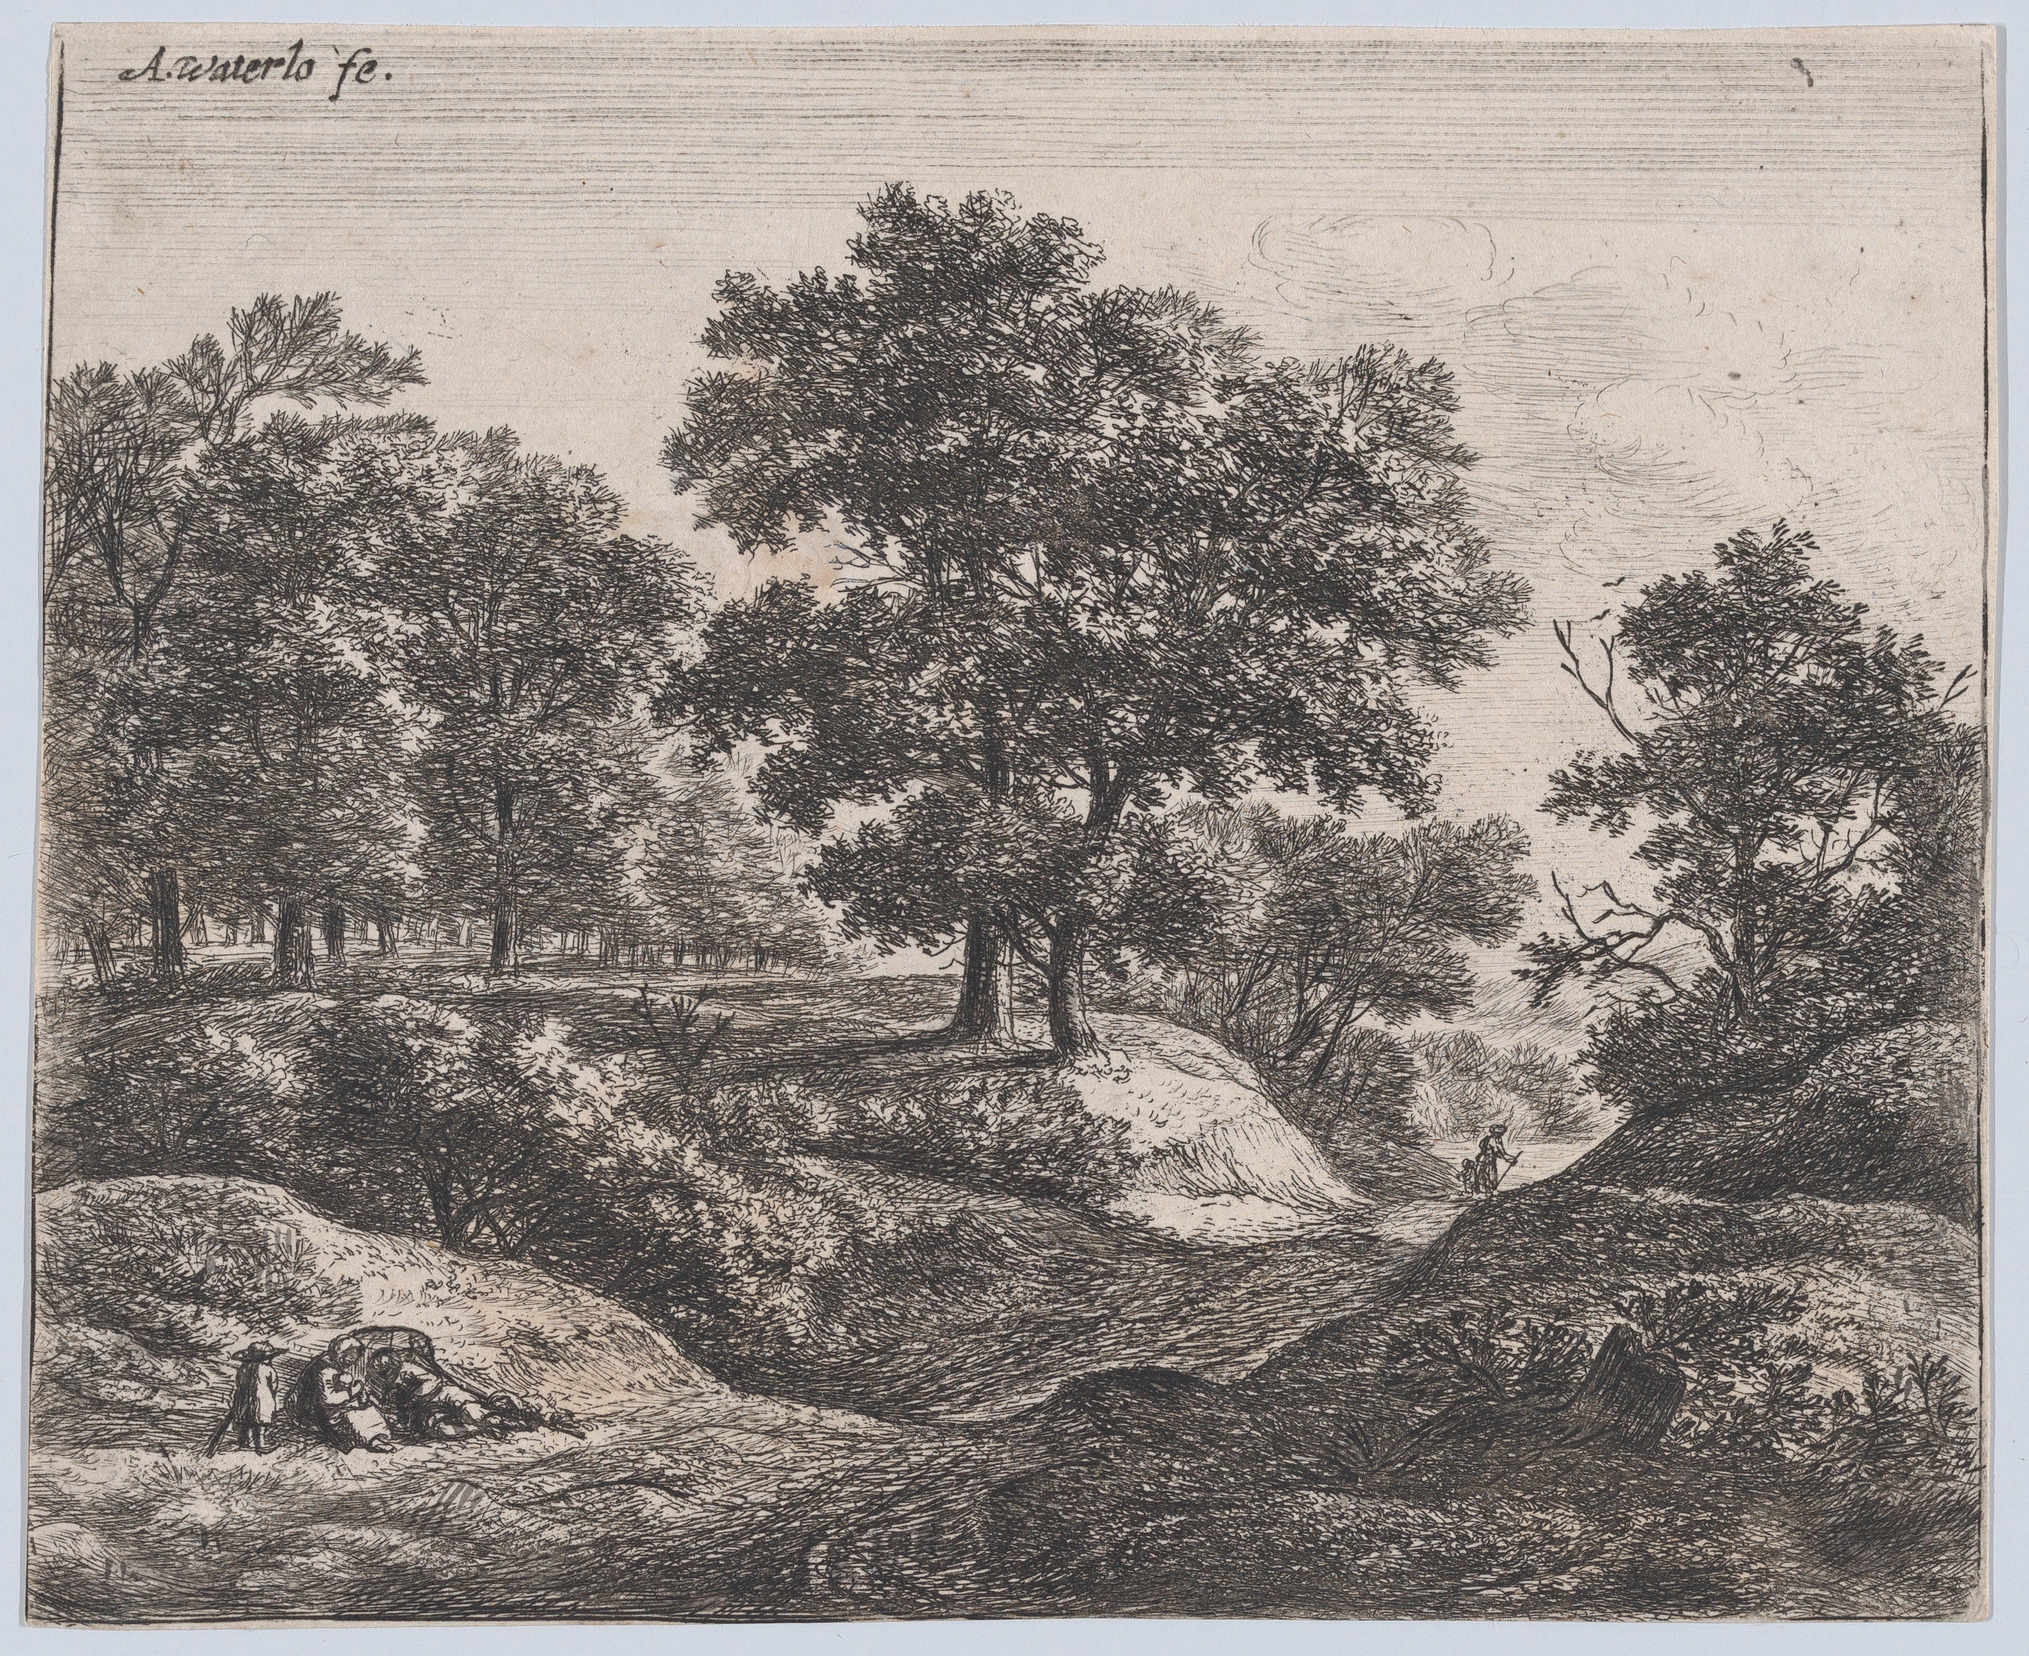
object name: print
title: Family at Rest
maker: anthonie waterloo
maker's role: artist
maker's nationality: dutch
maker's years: 1609-1690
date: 1601-1700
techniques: etching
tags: human figures,forests,family